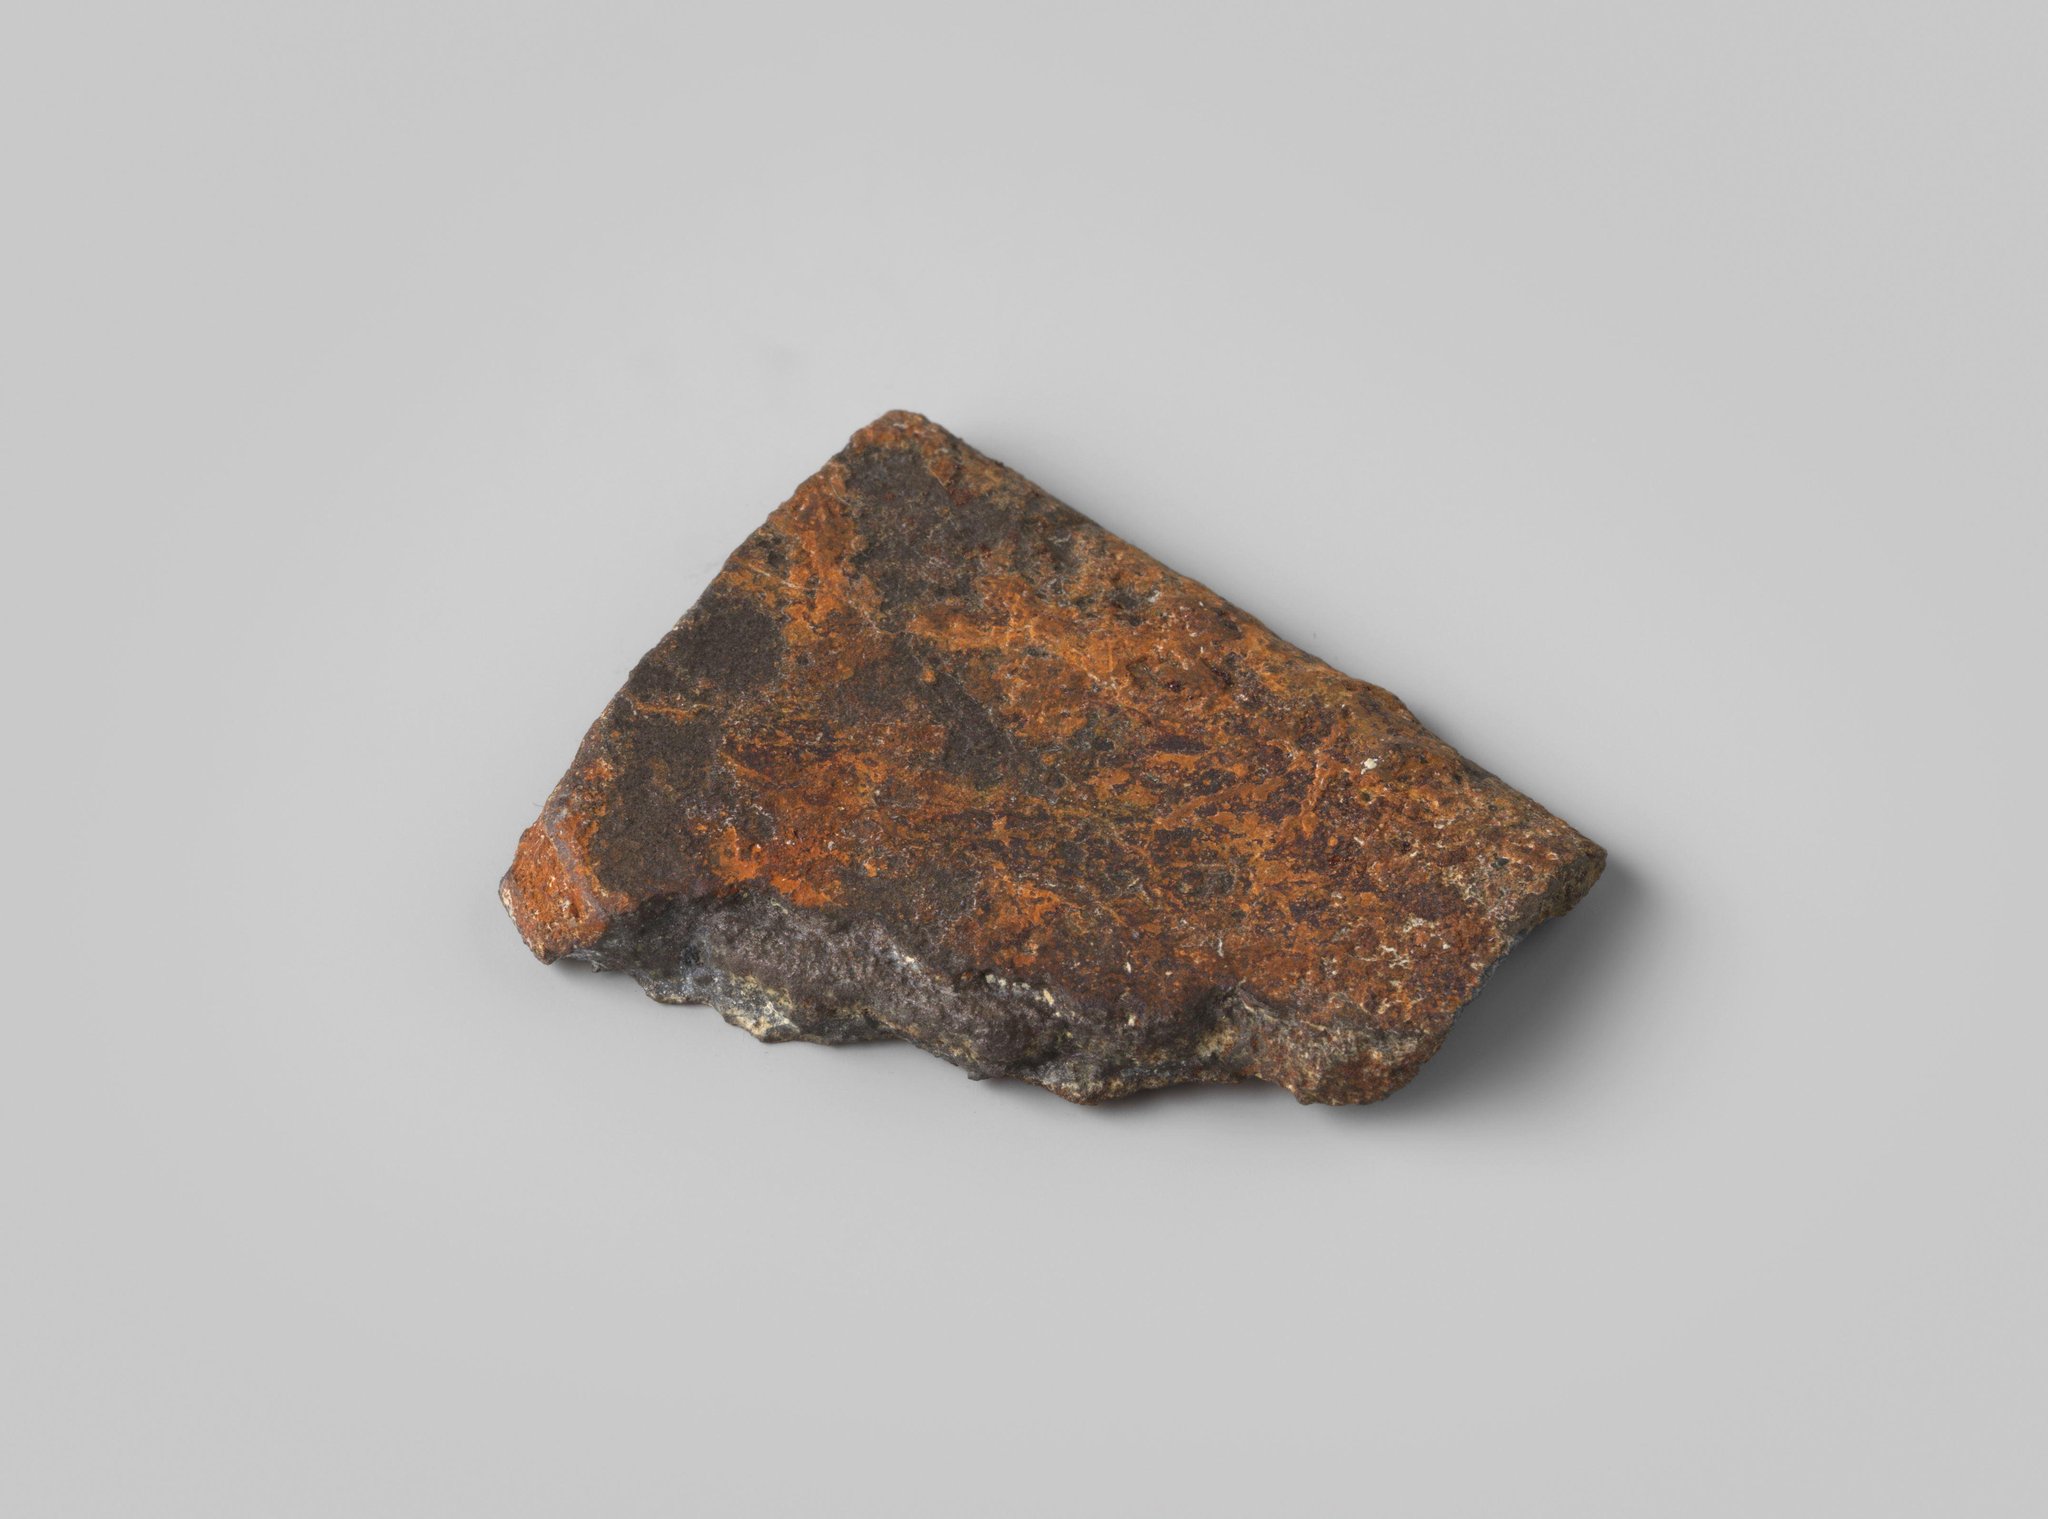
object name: whetstone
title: Slijpsteen uit het wrak van de Oost-Indiëvaarder Hollandia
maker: Anonymous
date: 1700-1743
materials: stone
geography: netherlands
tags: verenigde oostindische compagnie, hollandia (schip), annet